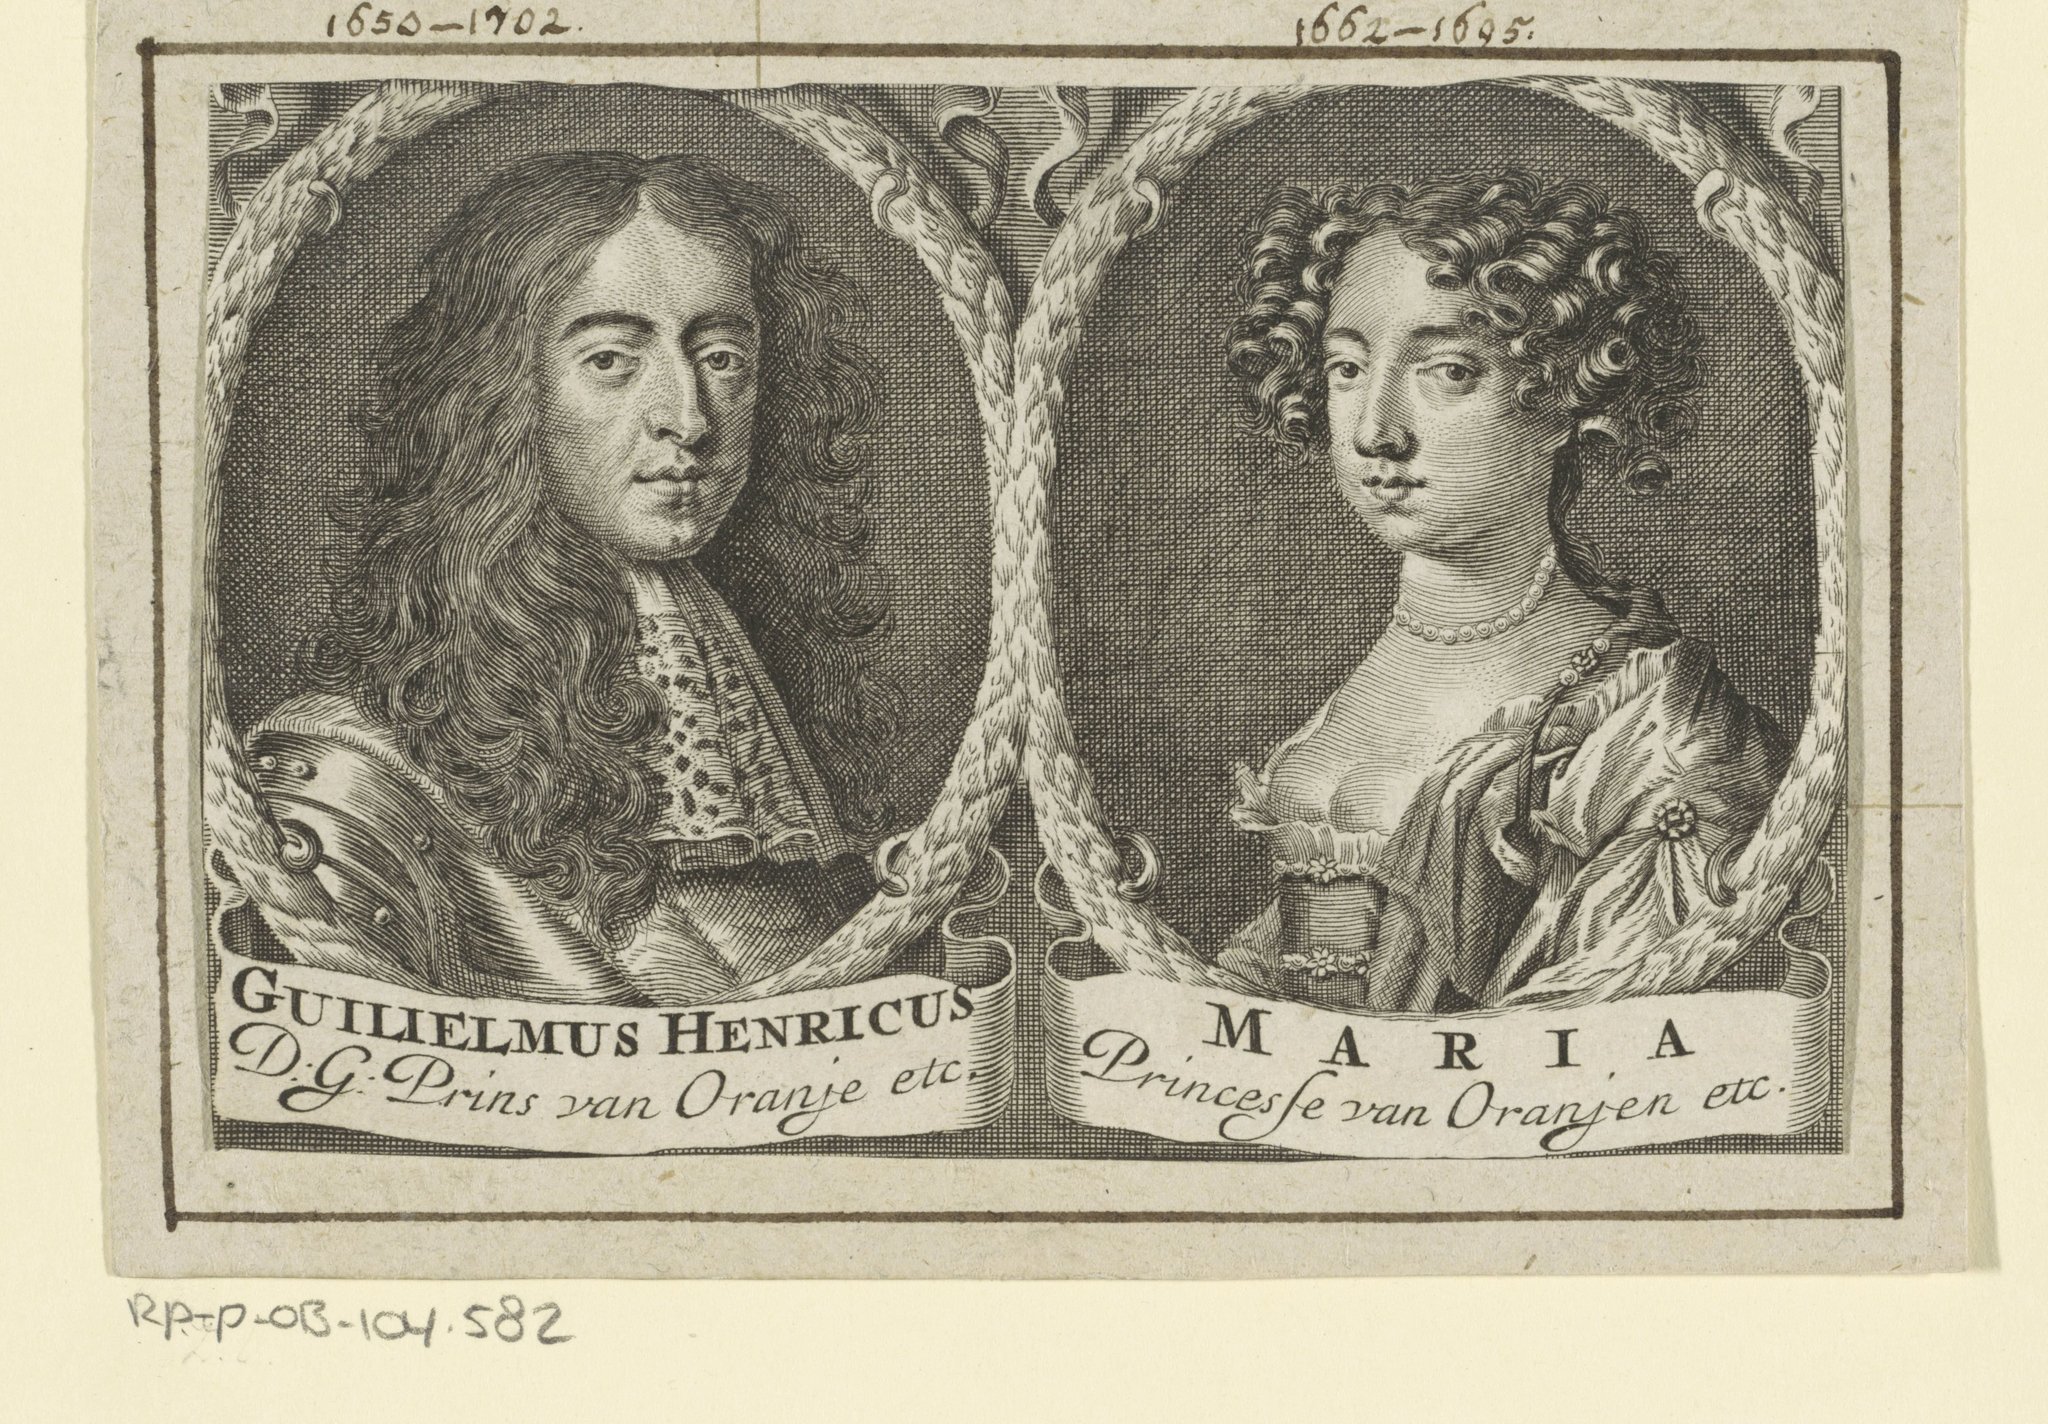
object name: print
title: Portretten van Willem III, prins van Oranje, en Maria II Stuart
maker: Anonymous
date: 1688-1749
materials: paper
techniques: engraving, etching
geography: low countries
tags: william iii (prince of orange and king of england, scotland, and ireland), london, maria ii stuart (koningin van engeland, schotland en ierland)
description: De hier vermelde titel verwijst naar de hoogst verkregen titel van de geportretteerde, niet per se naar de titel die de geportretteerde op deze voorstelling draagt.